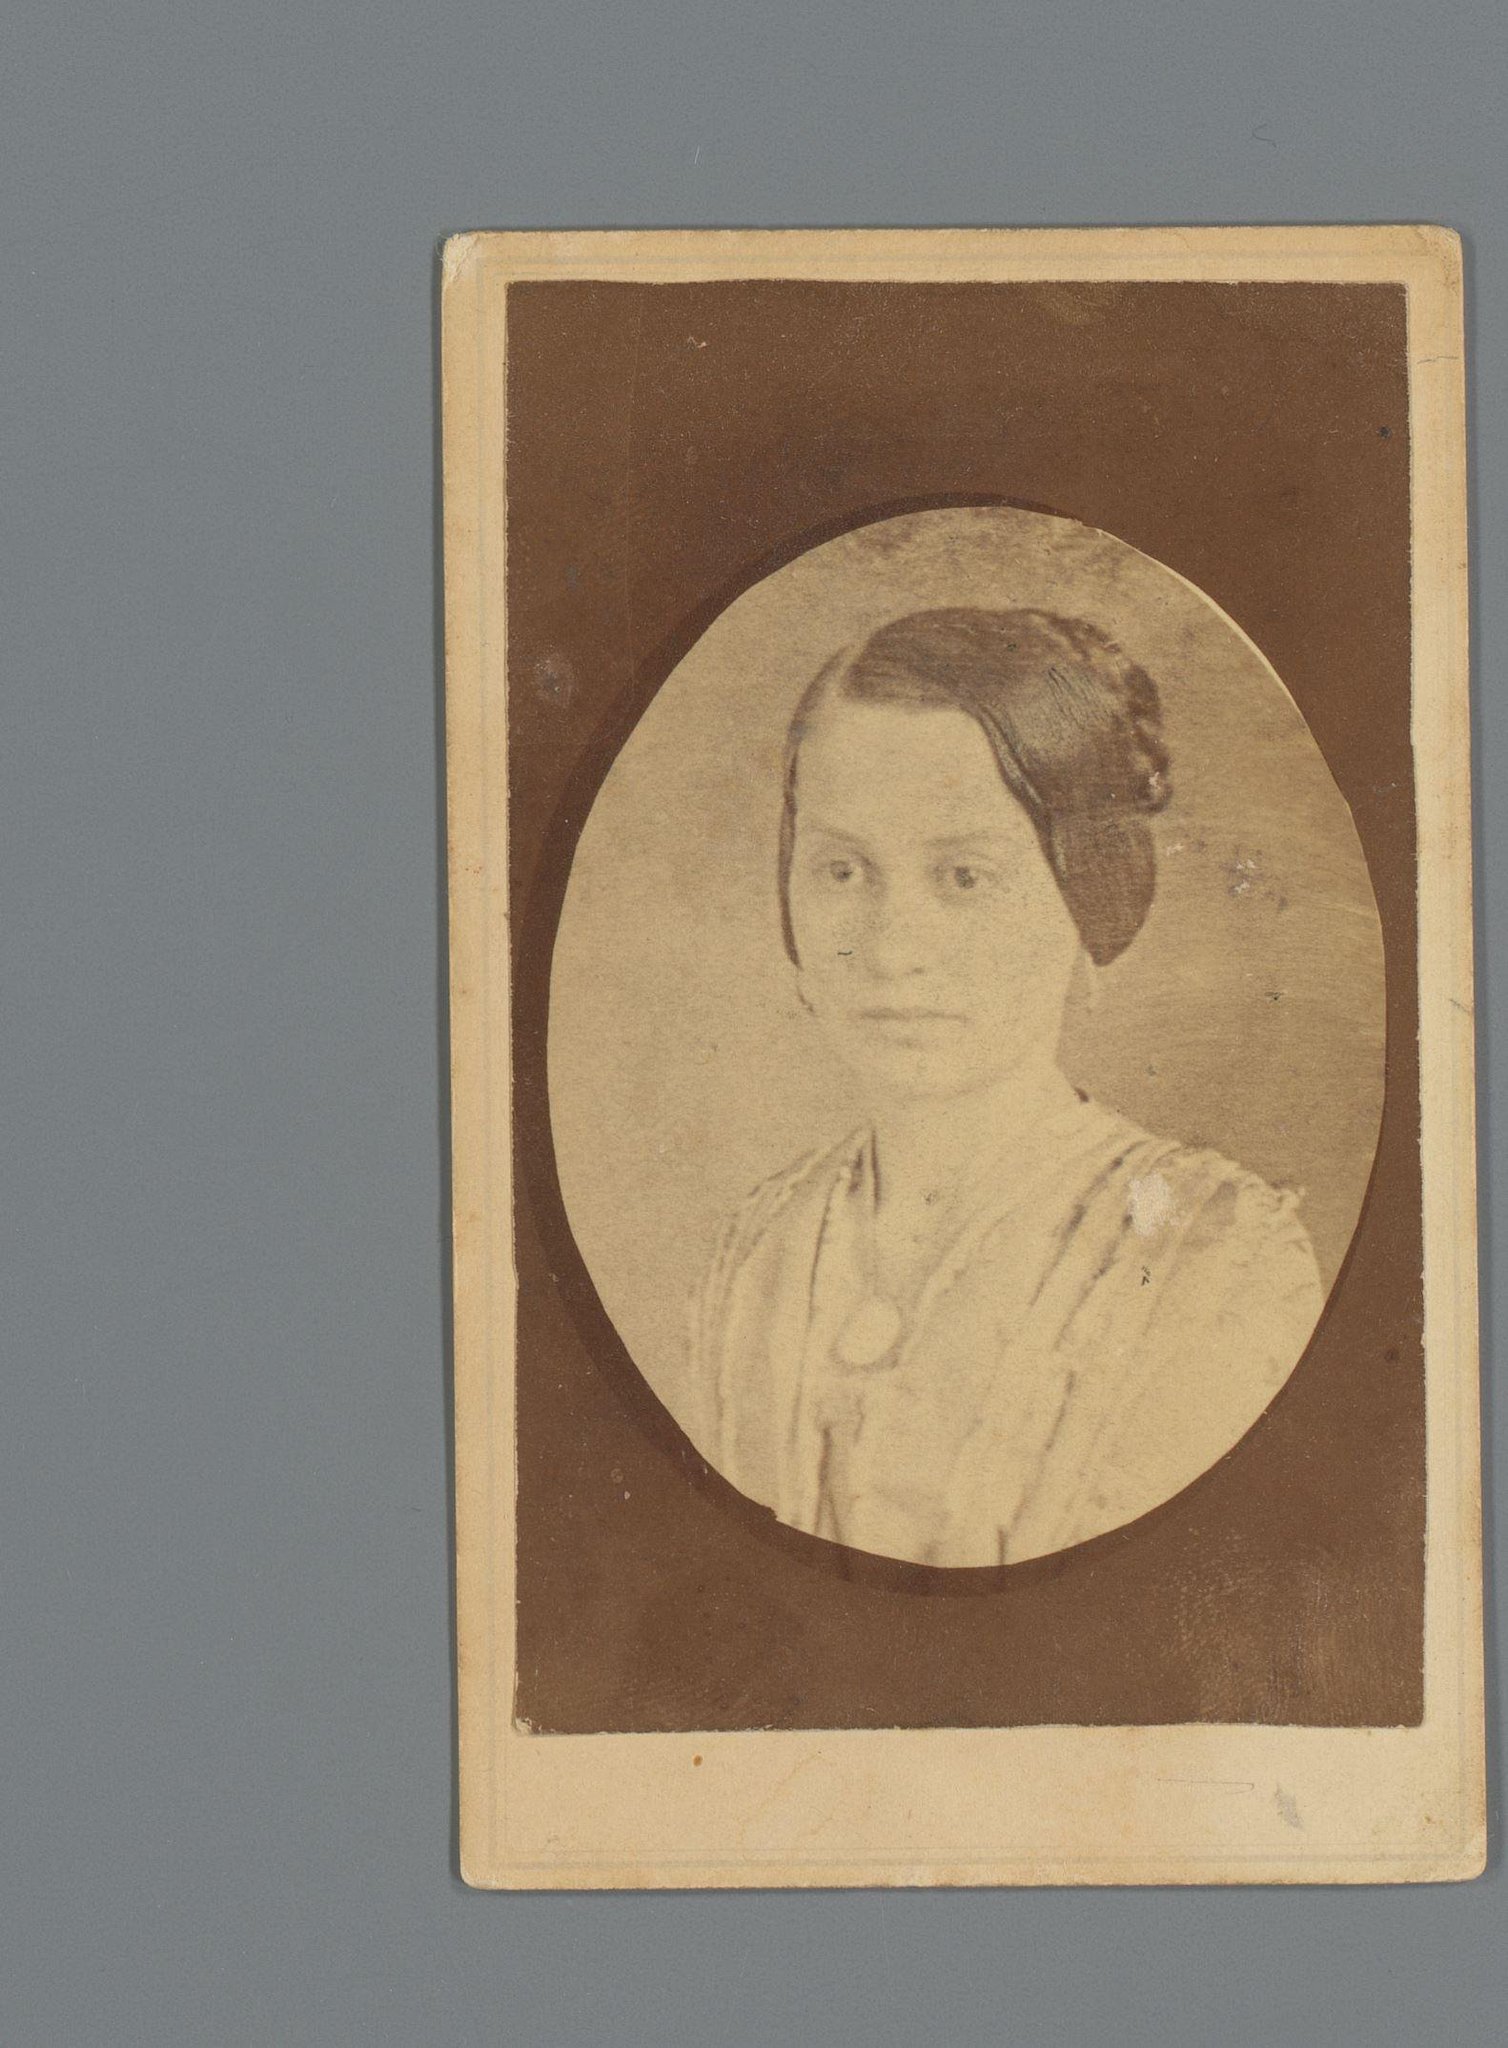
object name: photograph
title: Portret van een onbekende jonge vrouw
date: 1871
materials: cardboard, paper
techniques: albumen print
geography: henry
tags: adolescent, young woman, maiden, anonymous historical person portrayed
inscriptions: inscription: ‘KNIGHT & FOX'S [doorgestreept]/ Lowes/ Fine Art Gallery/ Edwards Street,/ HENRY,/ ILL./ Negatives retained for future orders/ No. of Negative/ Date. June 1st 1871’